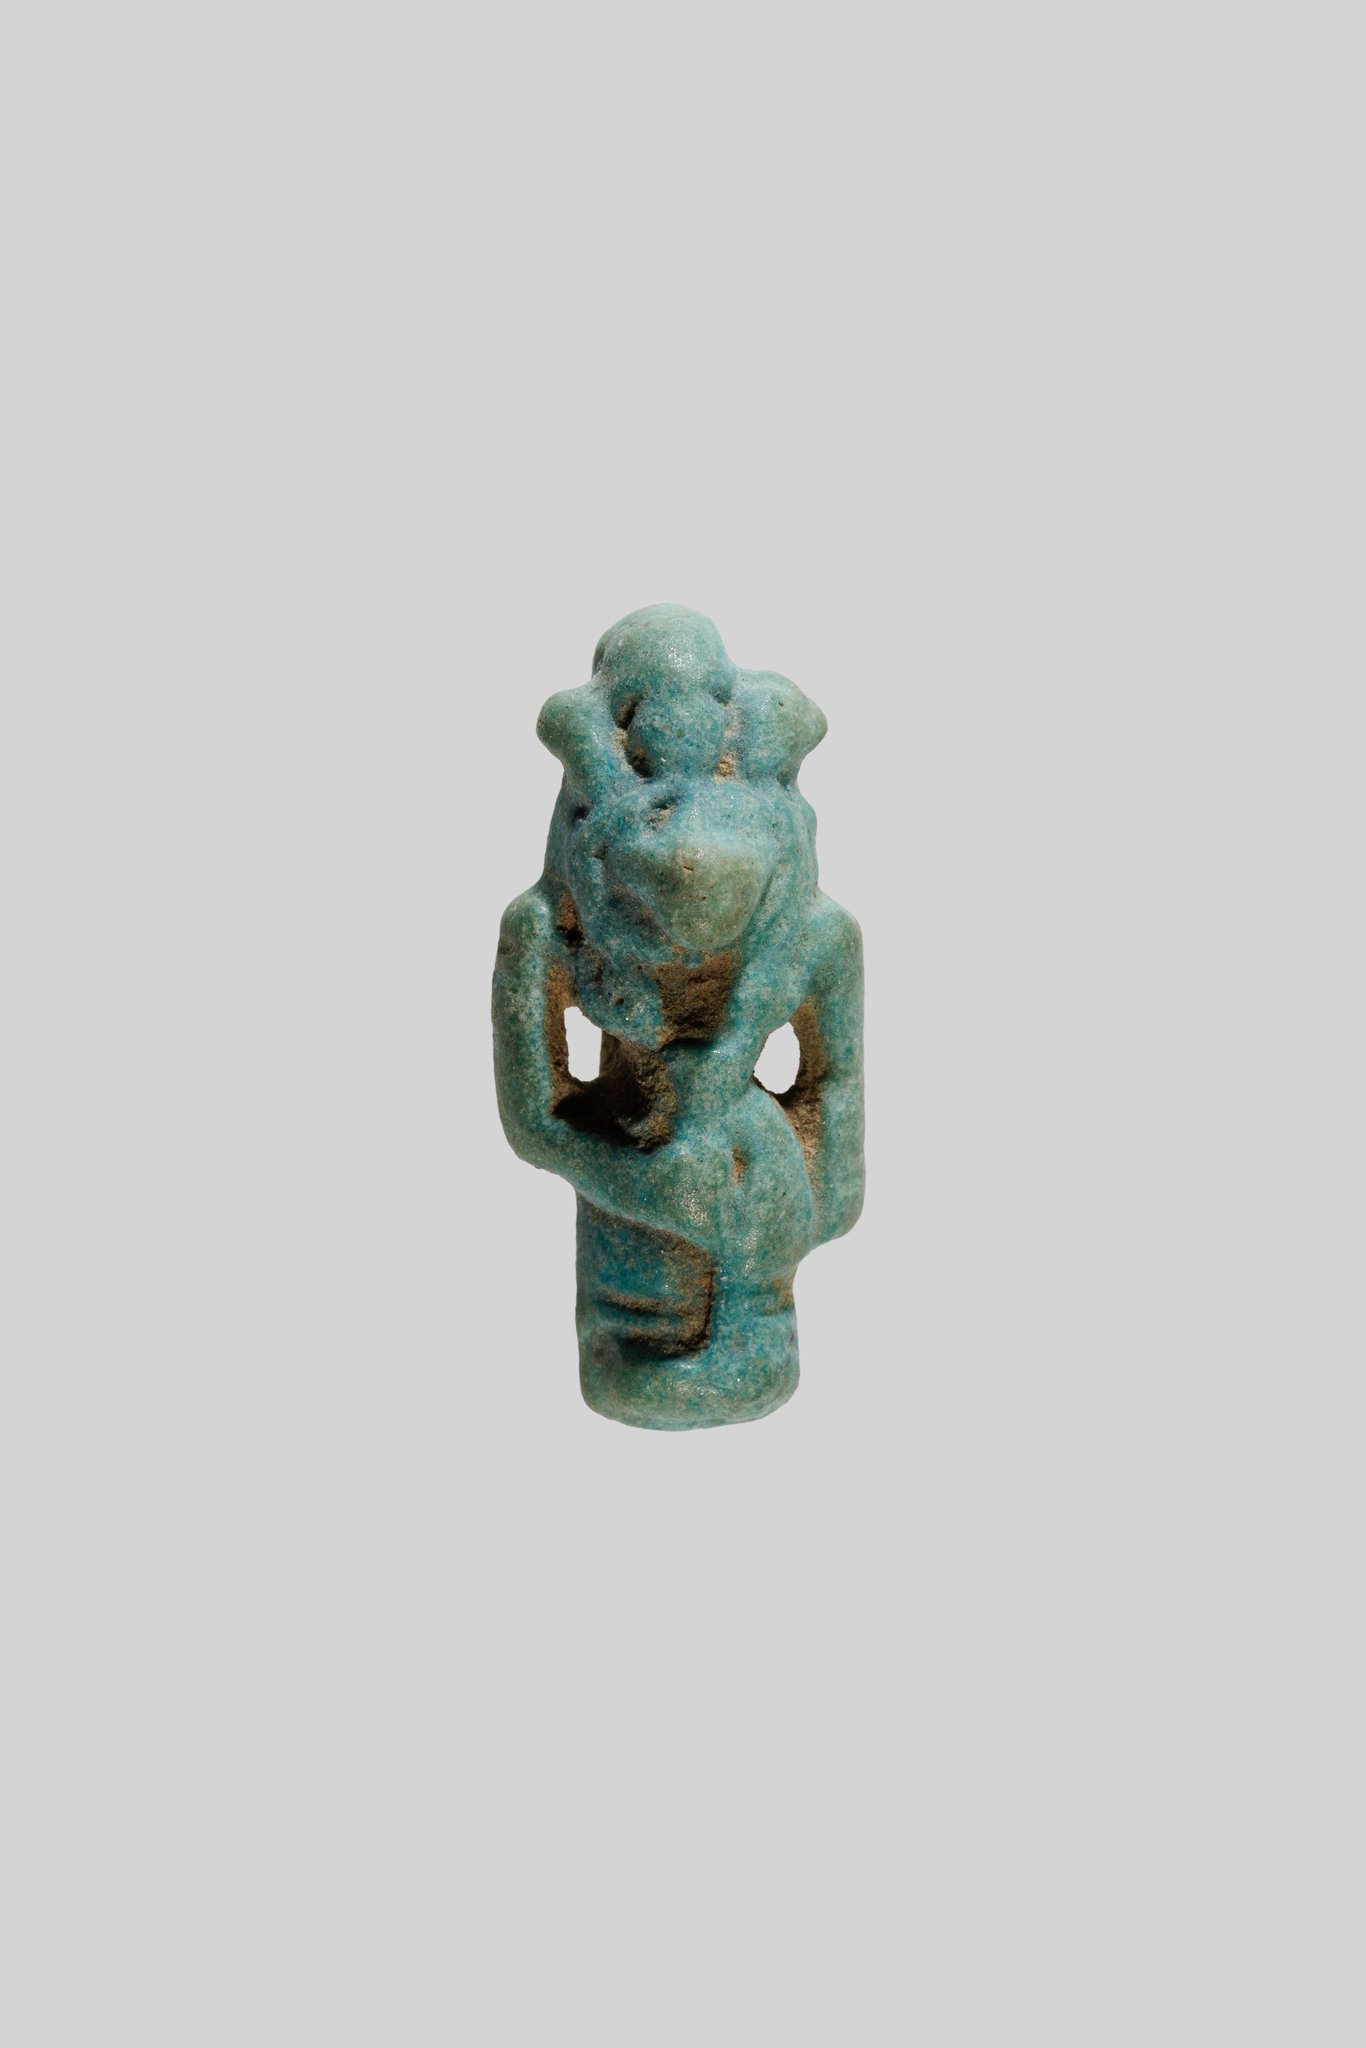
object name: amulet, aegis, bastet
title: Sakhmet or Bastet amulet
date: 1295-1070 BCE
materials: faience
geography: egypt